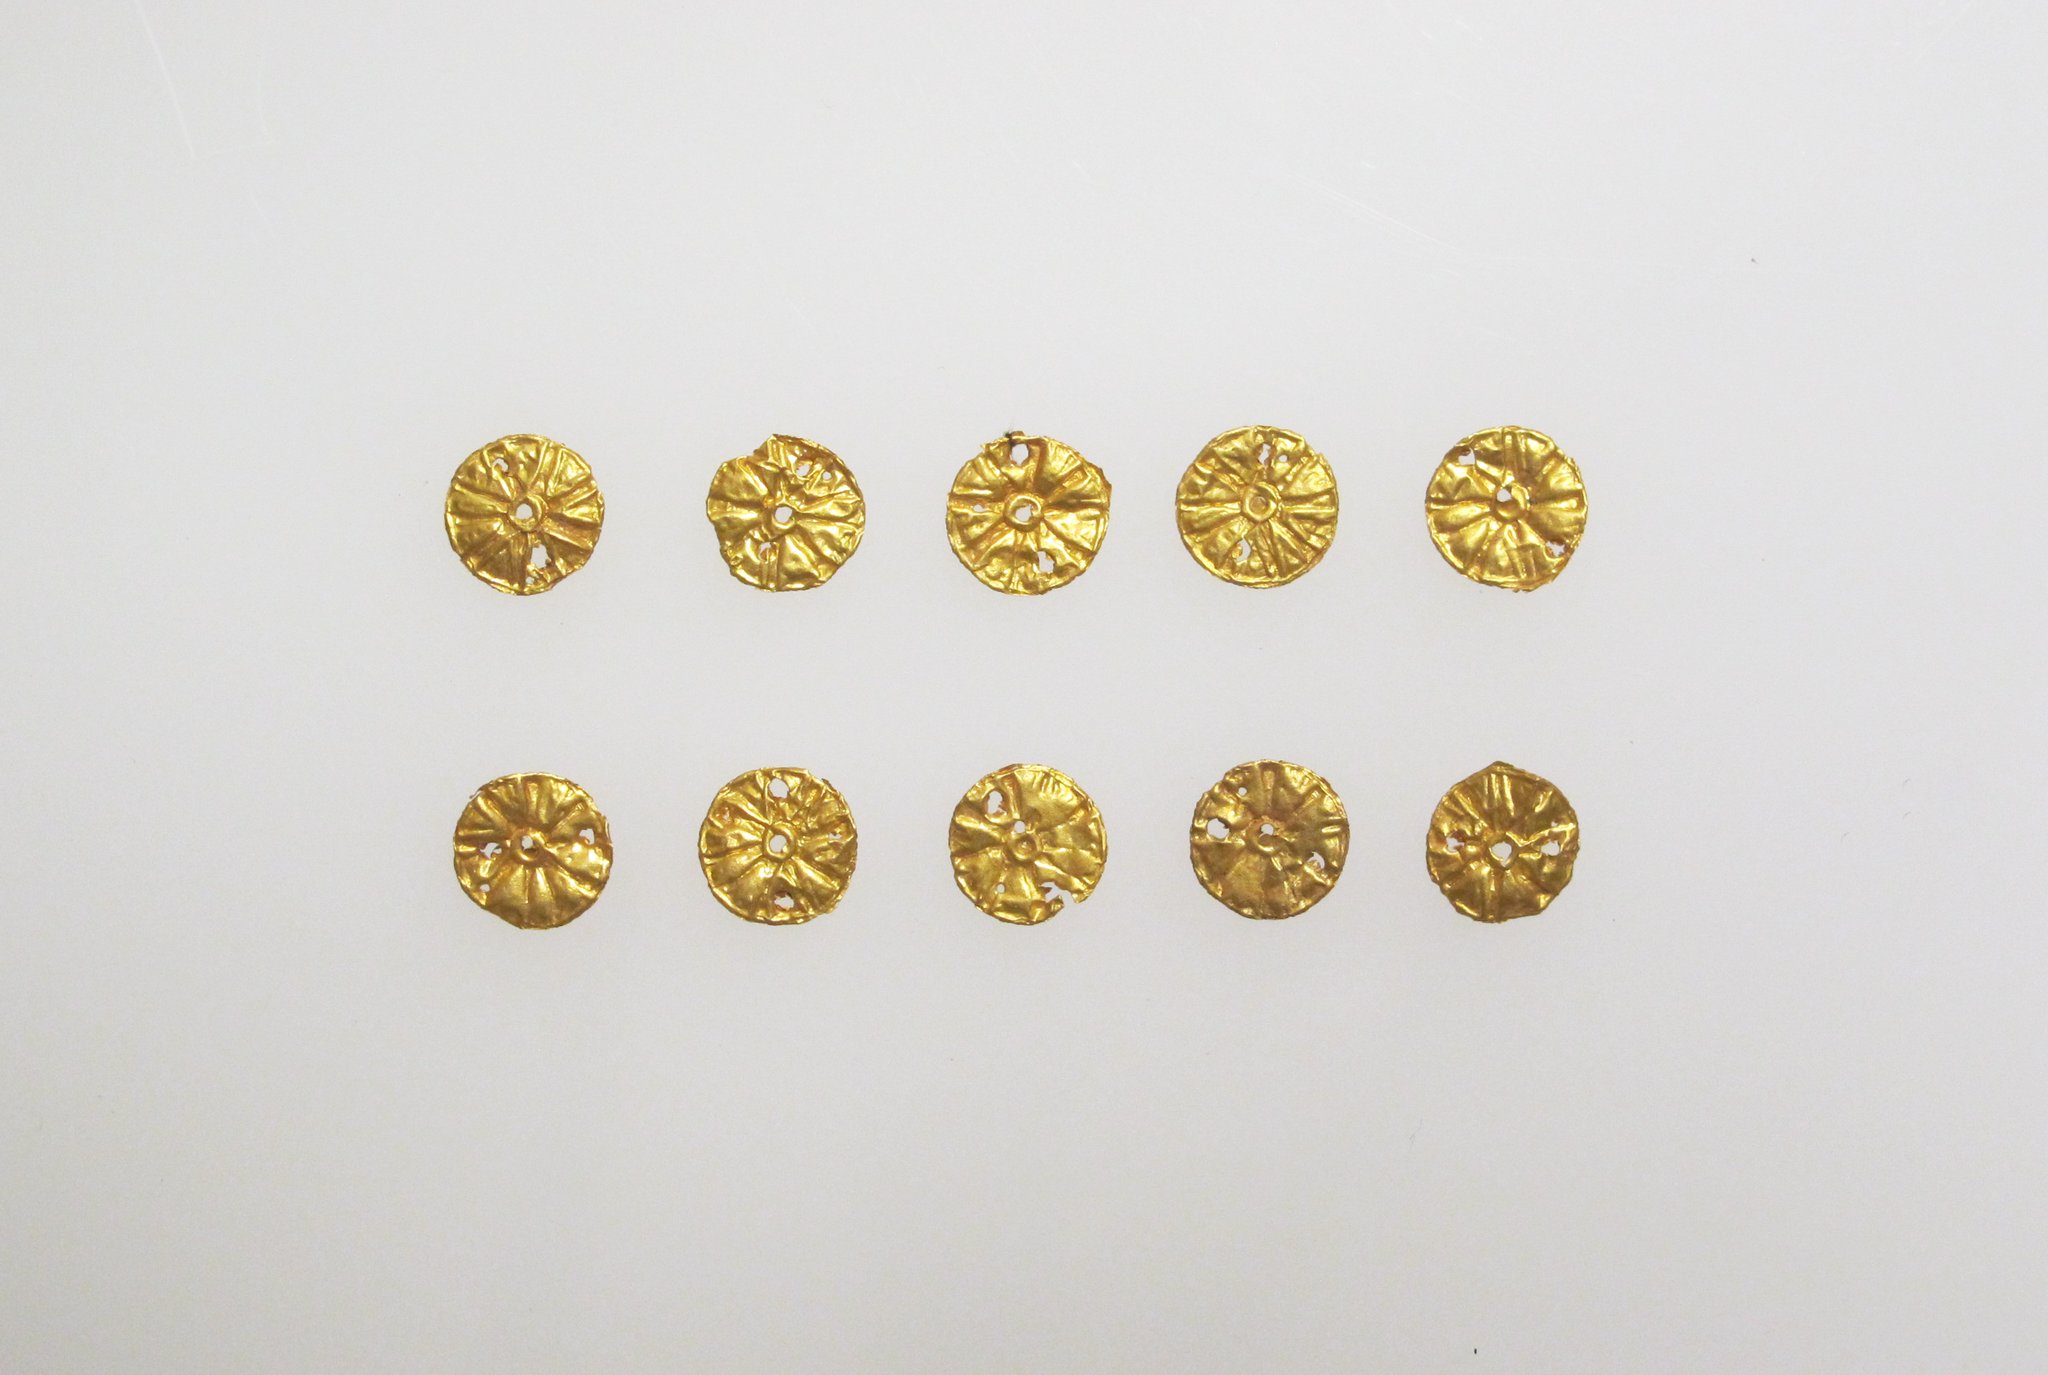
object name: bead ornament, circular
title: Bead ornaments, circular, 10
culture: roman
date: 201-300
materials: gold